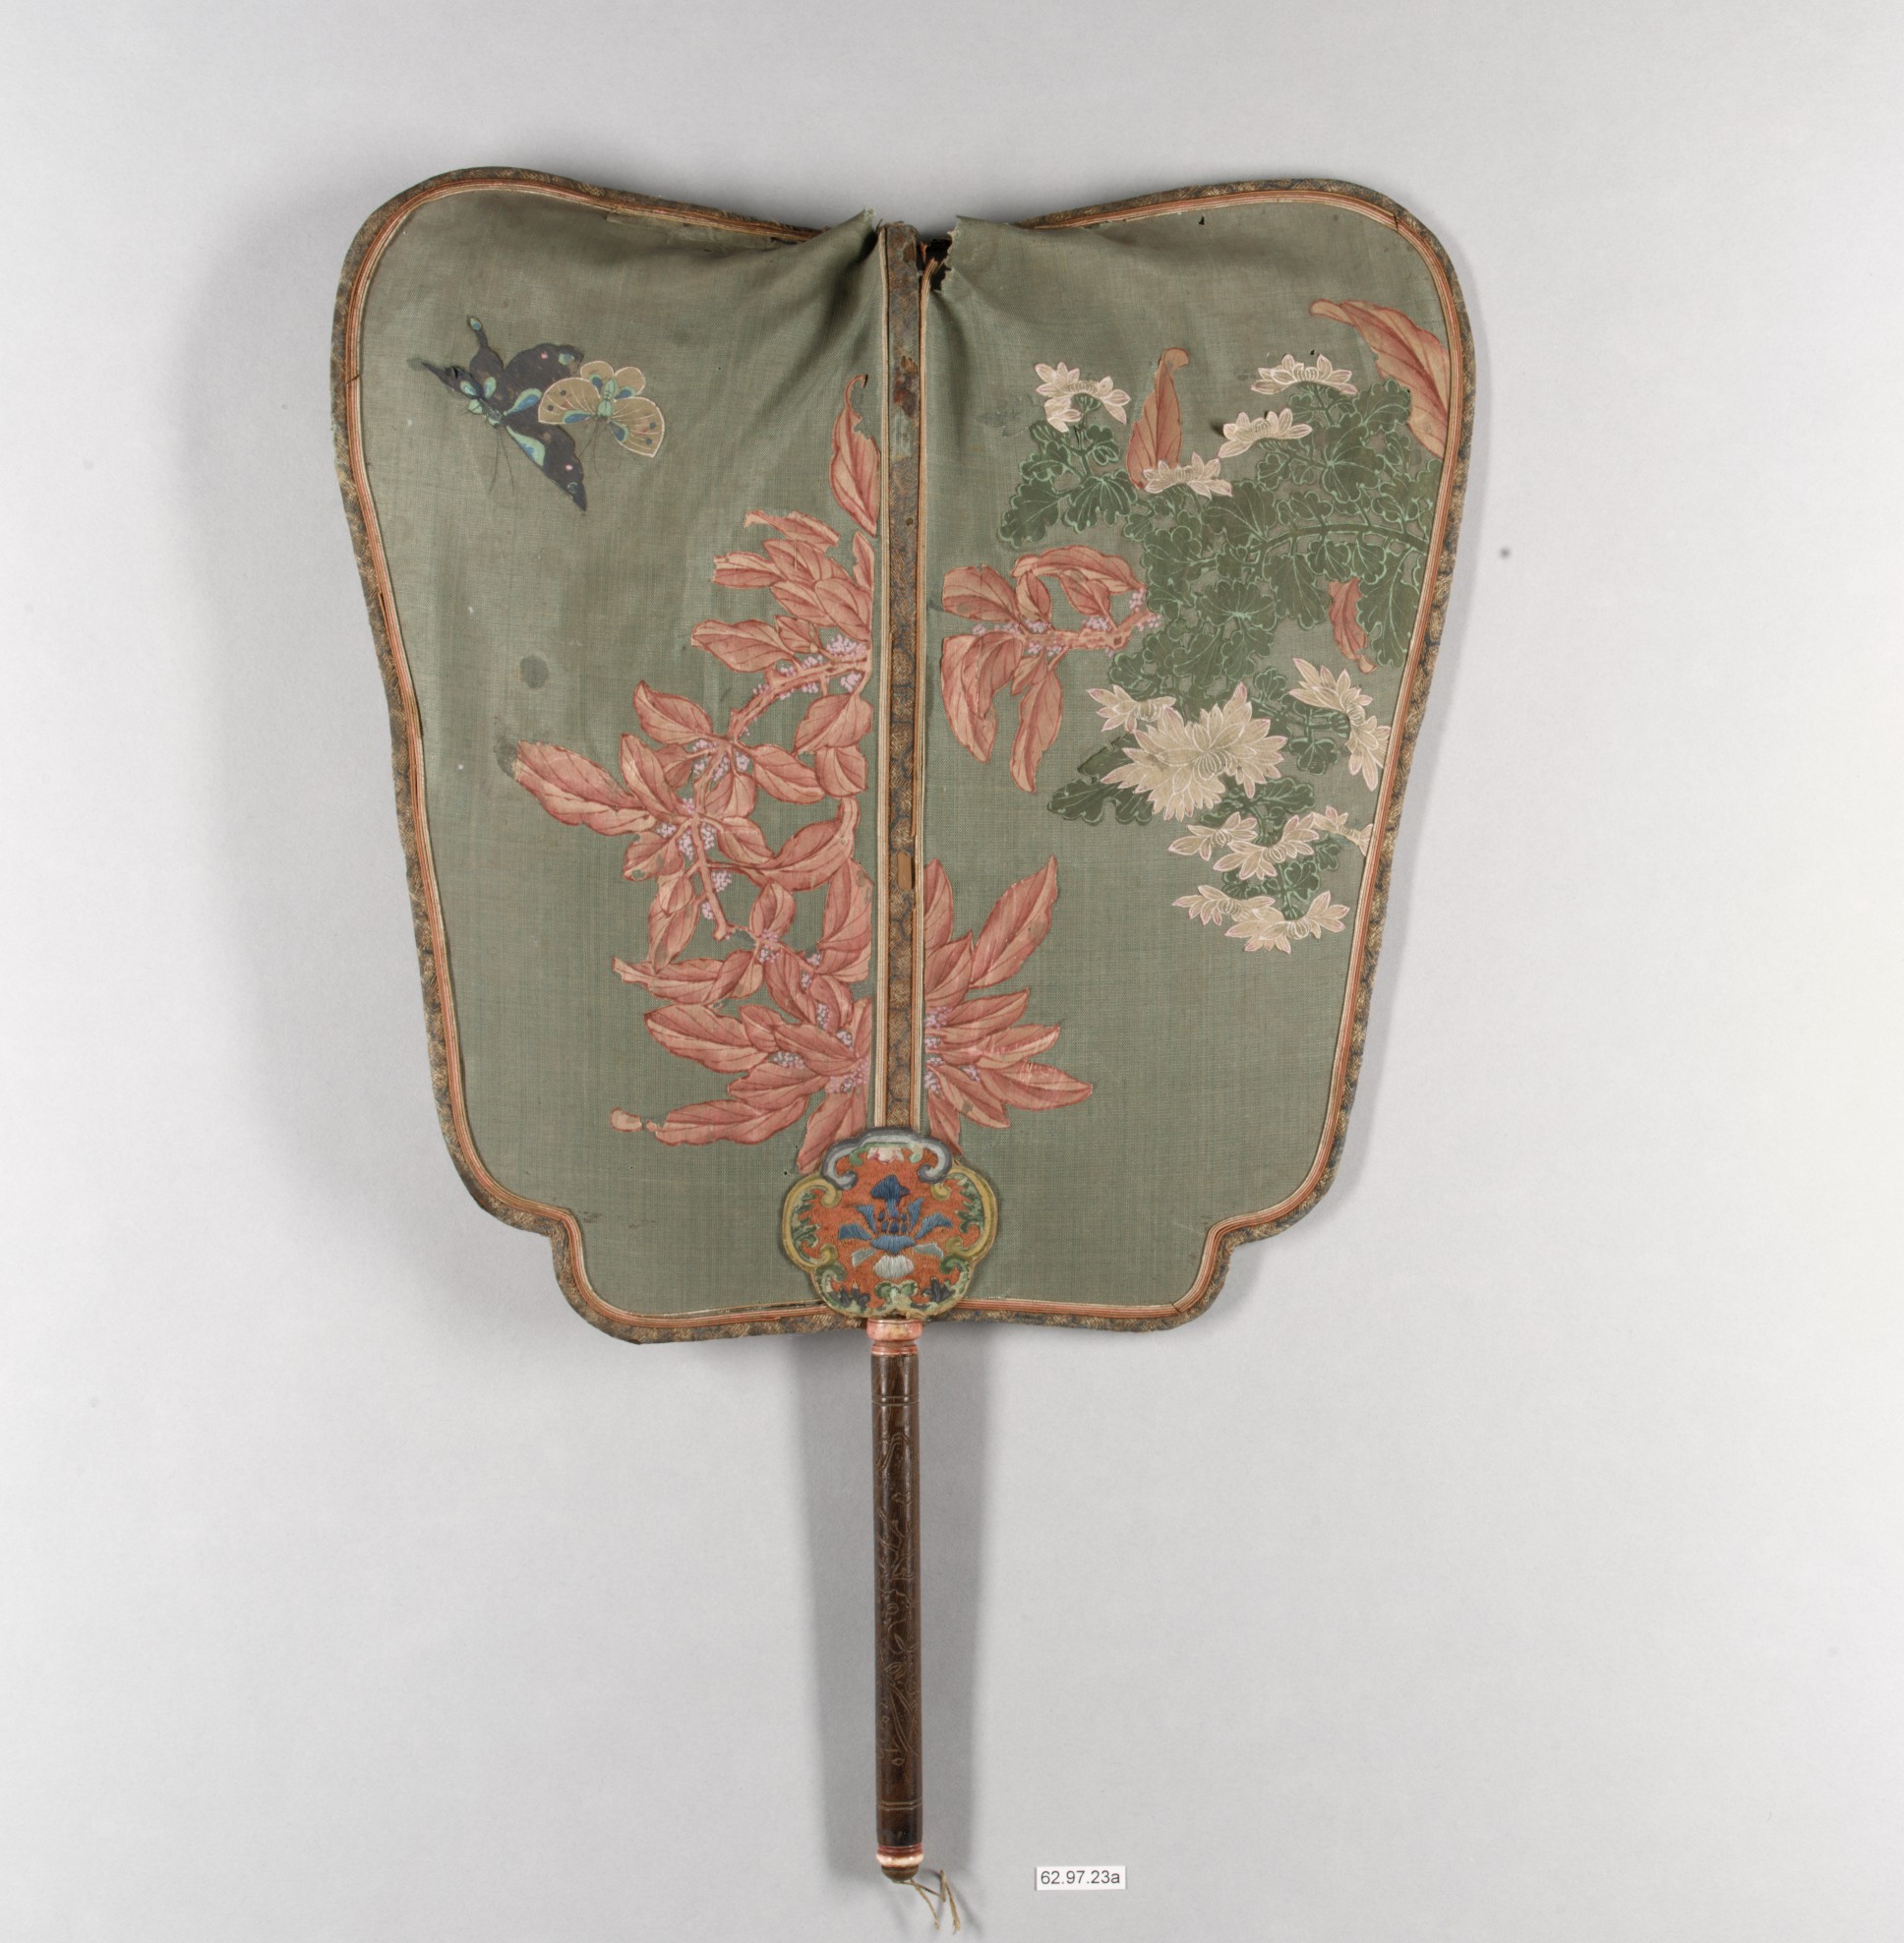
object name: fan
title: Fan with Flowers and Butterflies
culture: chinese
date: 1801-1900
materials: bamboo, paper, silk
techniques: painting, weave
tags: butterflies,flowers